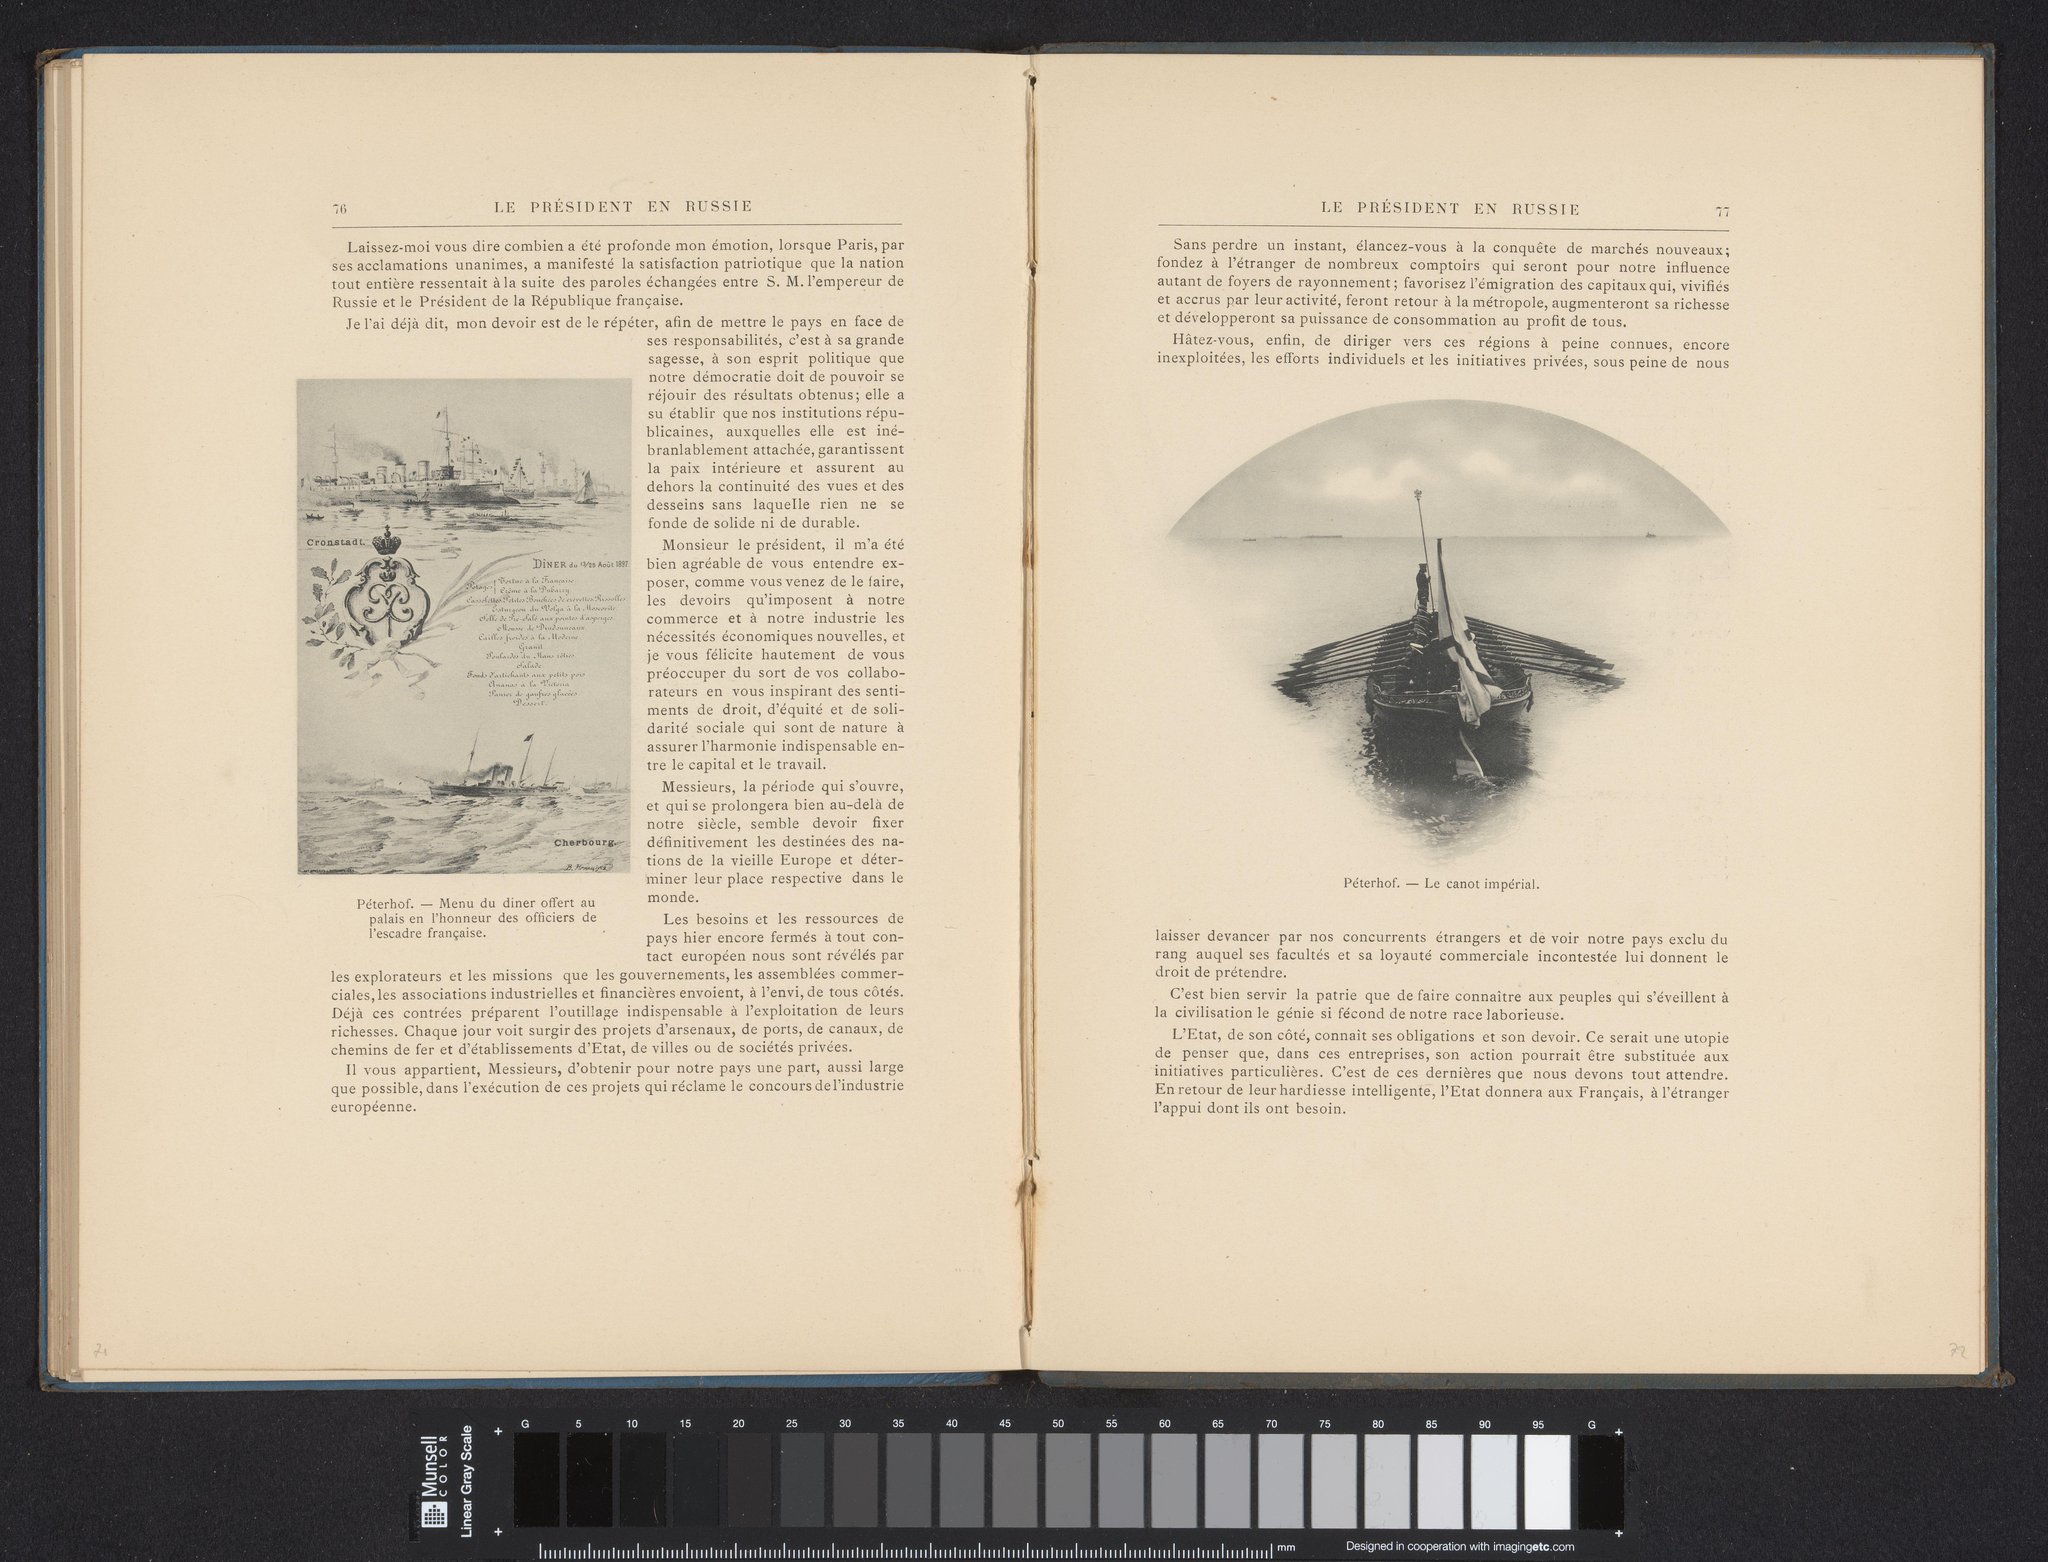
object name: page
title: Keizerlijke sloep te Peterhof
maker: Anonymous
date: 1897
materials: paper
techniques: photograph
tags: rowing-boat, canoe, etc.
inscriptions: inscription: ‘Péterhof.- Le canot impérial.’